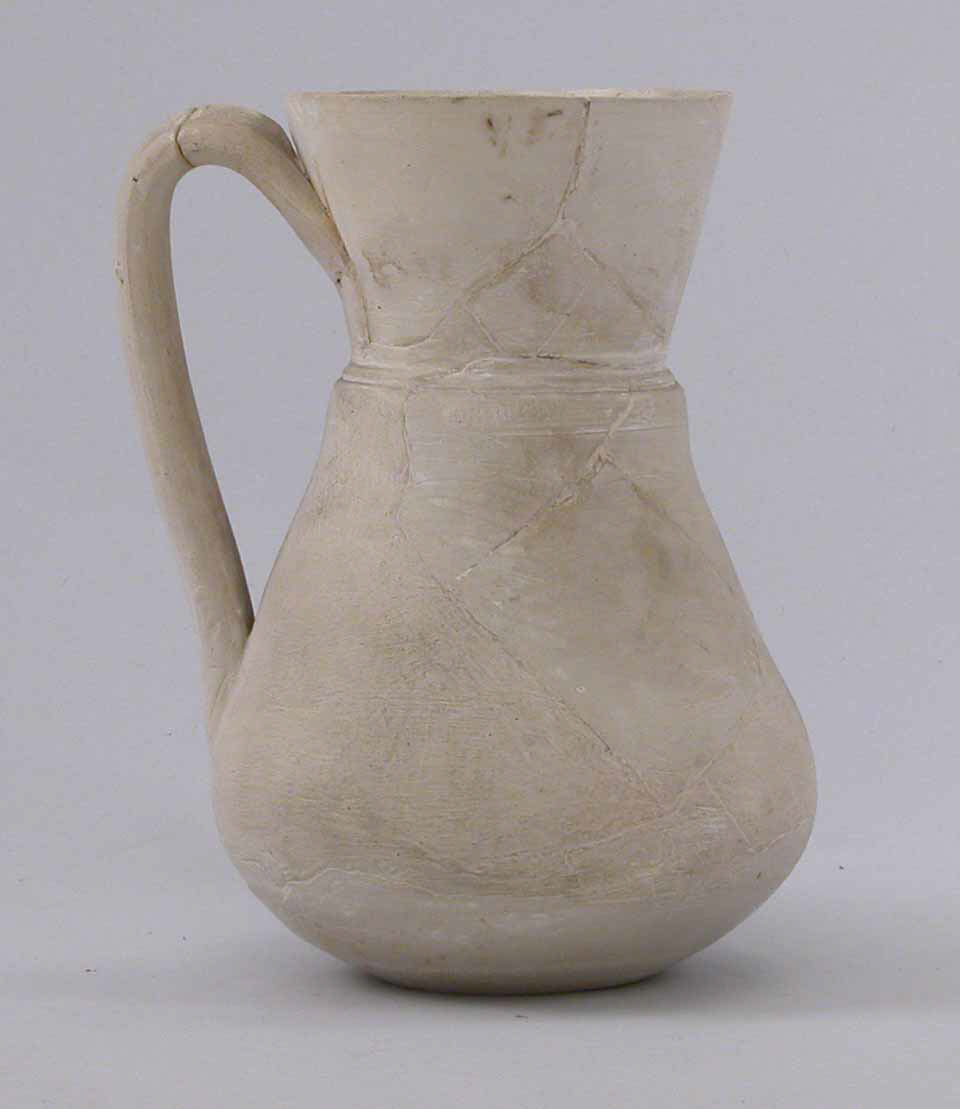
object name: ewer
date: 701-900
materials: earthenware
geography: iran